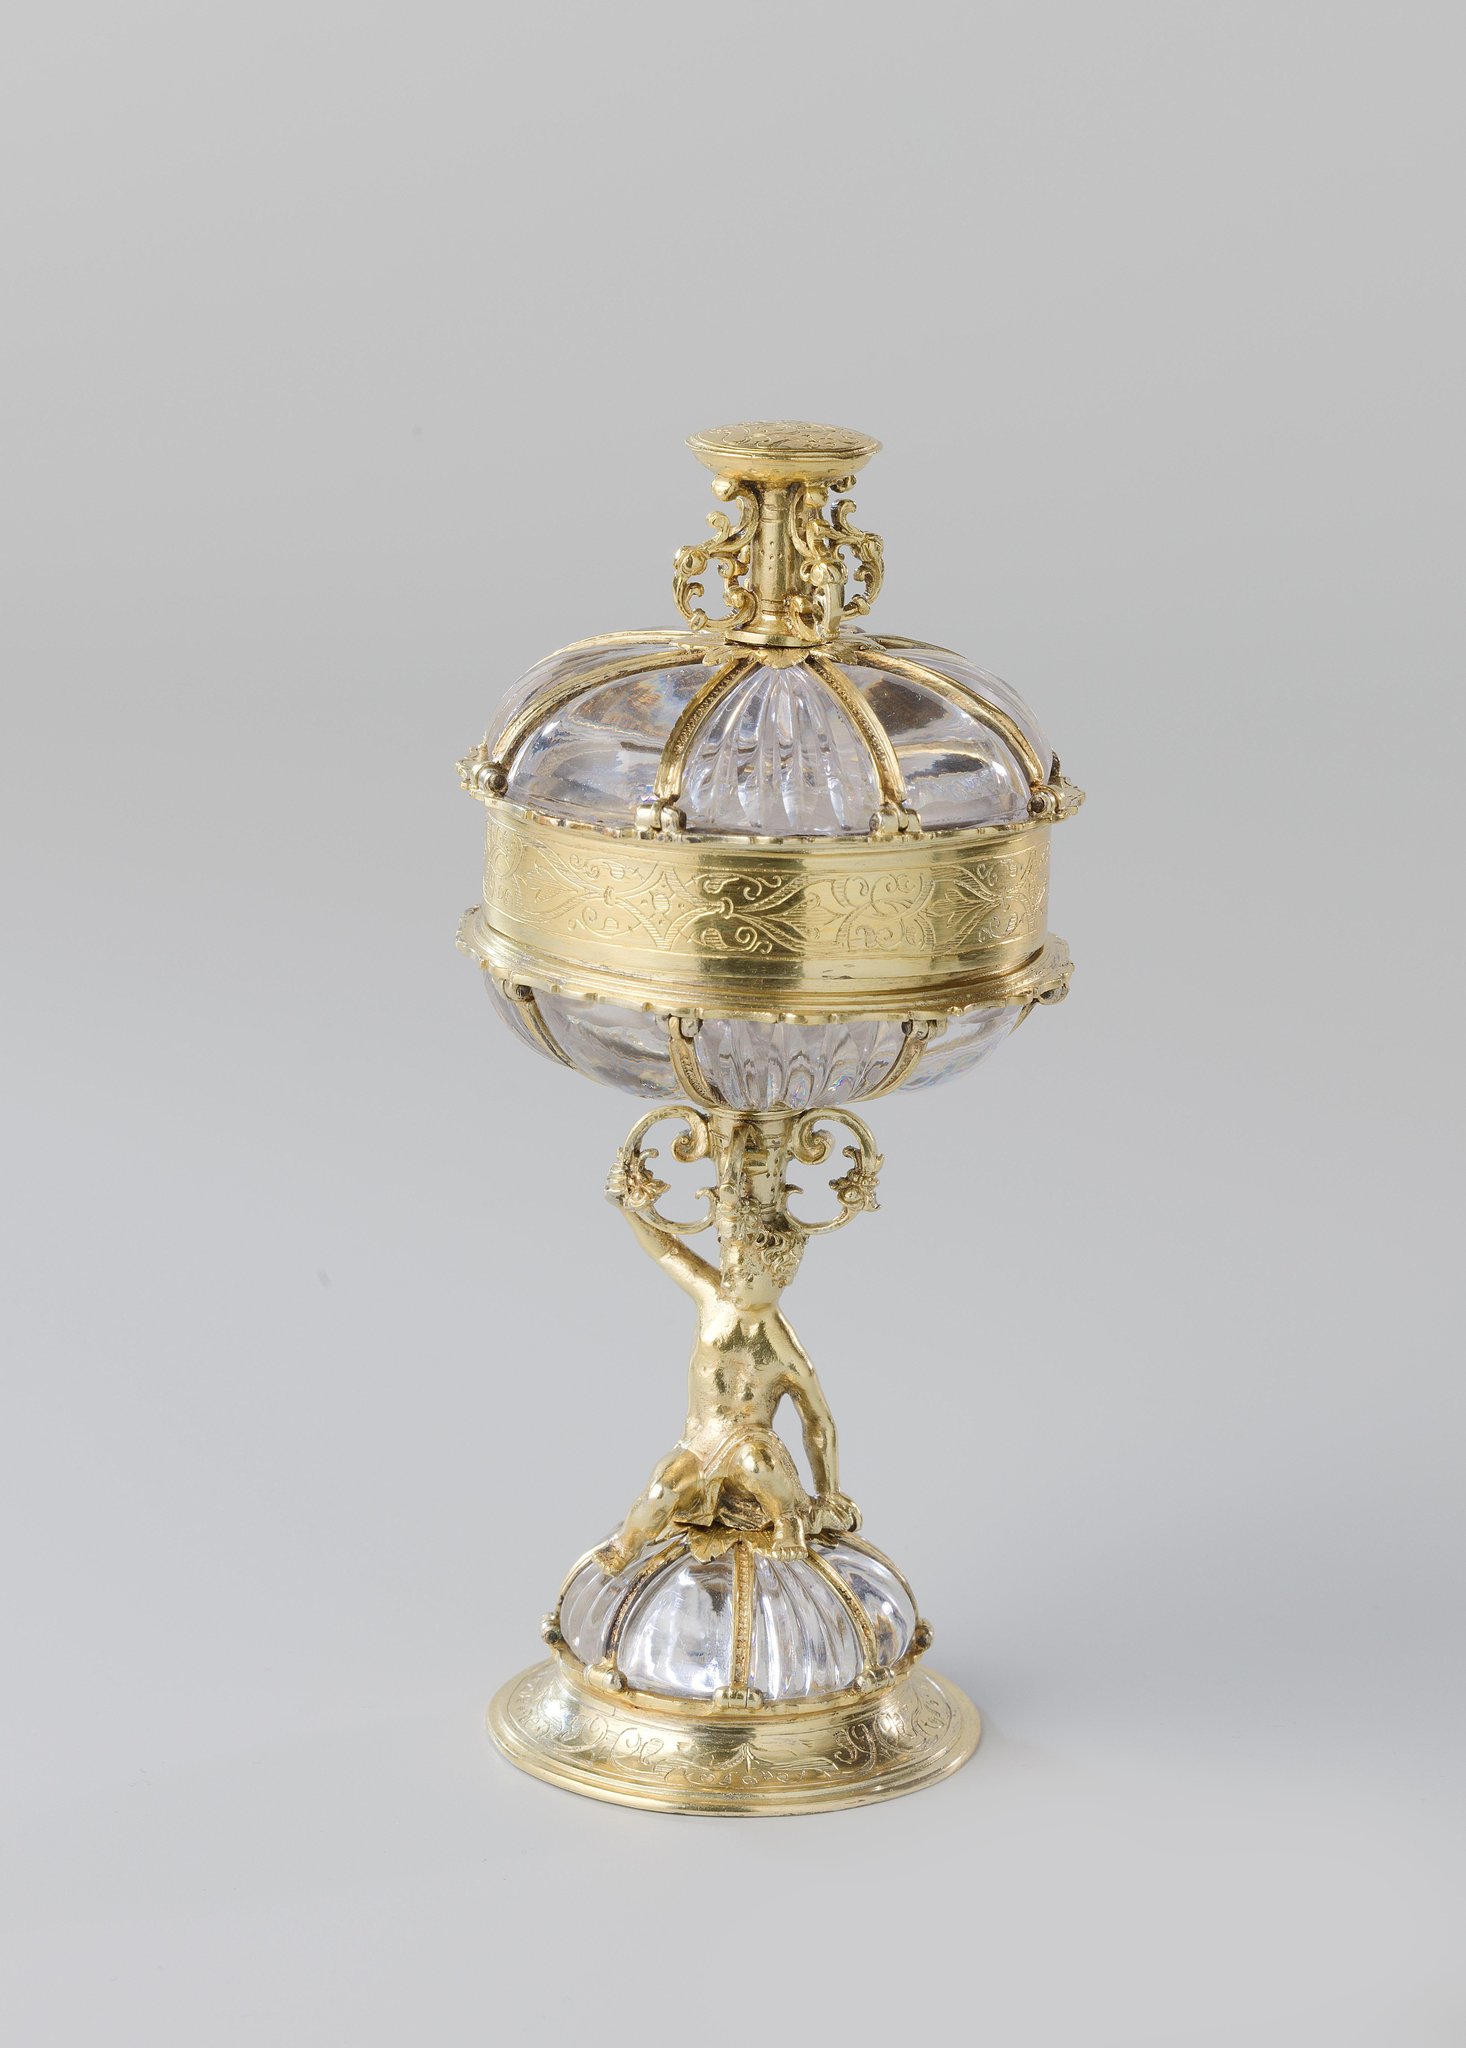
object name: goblet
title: Bokaal met montuur van verguld zilver. Op koepelvormige voet een naakte jongeling die met één hand het montuur van het vat vasthoudt.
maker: Anonymous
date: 1590-1610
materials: silver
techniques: gilding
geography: southern germany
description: Kleine bokaal met verguld zilveren montuur. Op de koepelvormige voet zit een naakte jongeling die met een hand het montuur van het vat vasthoudt.